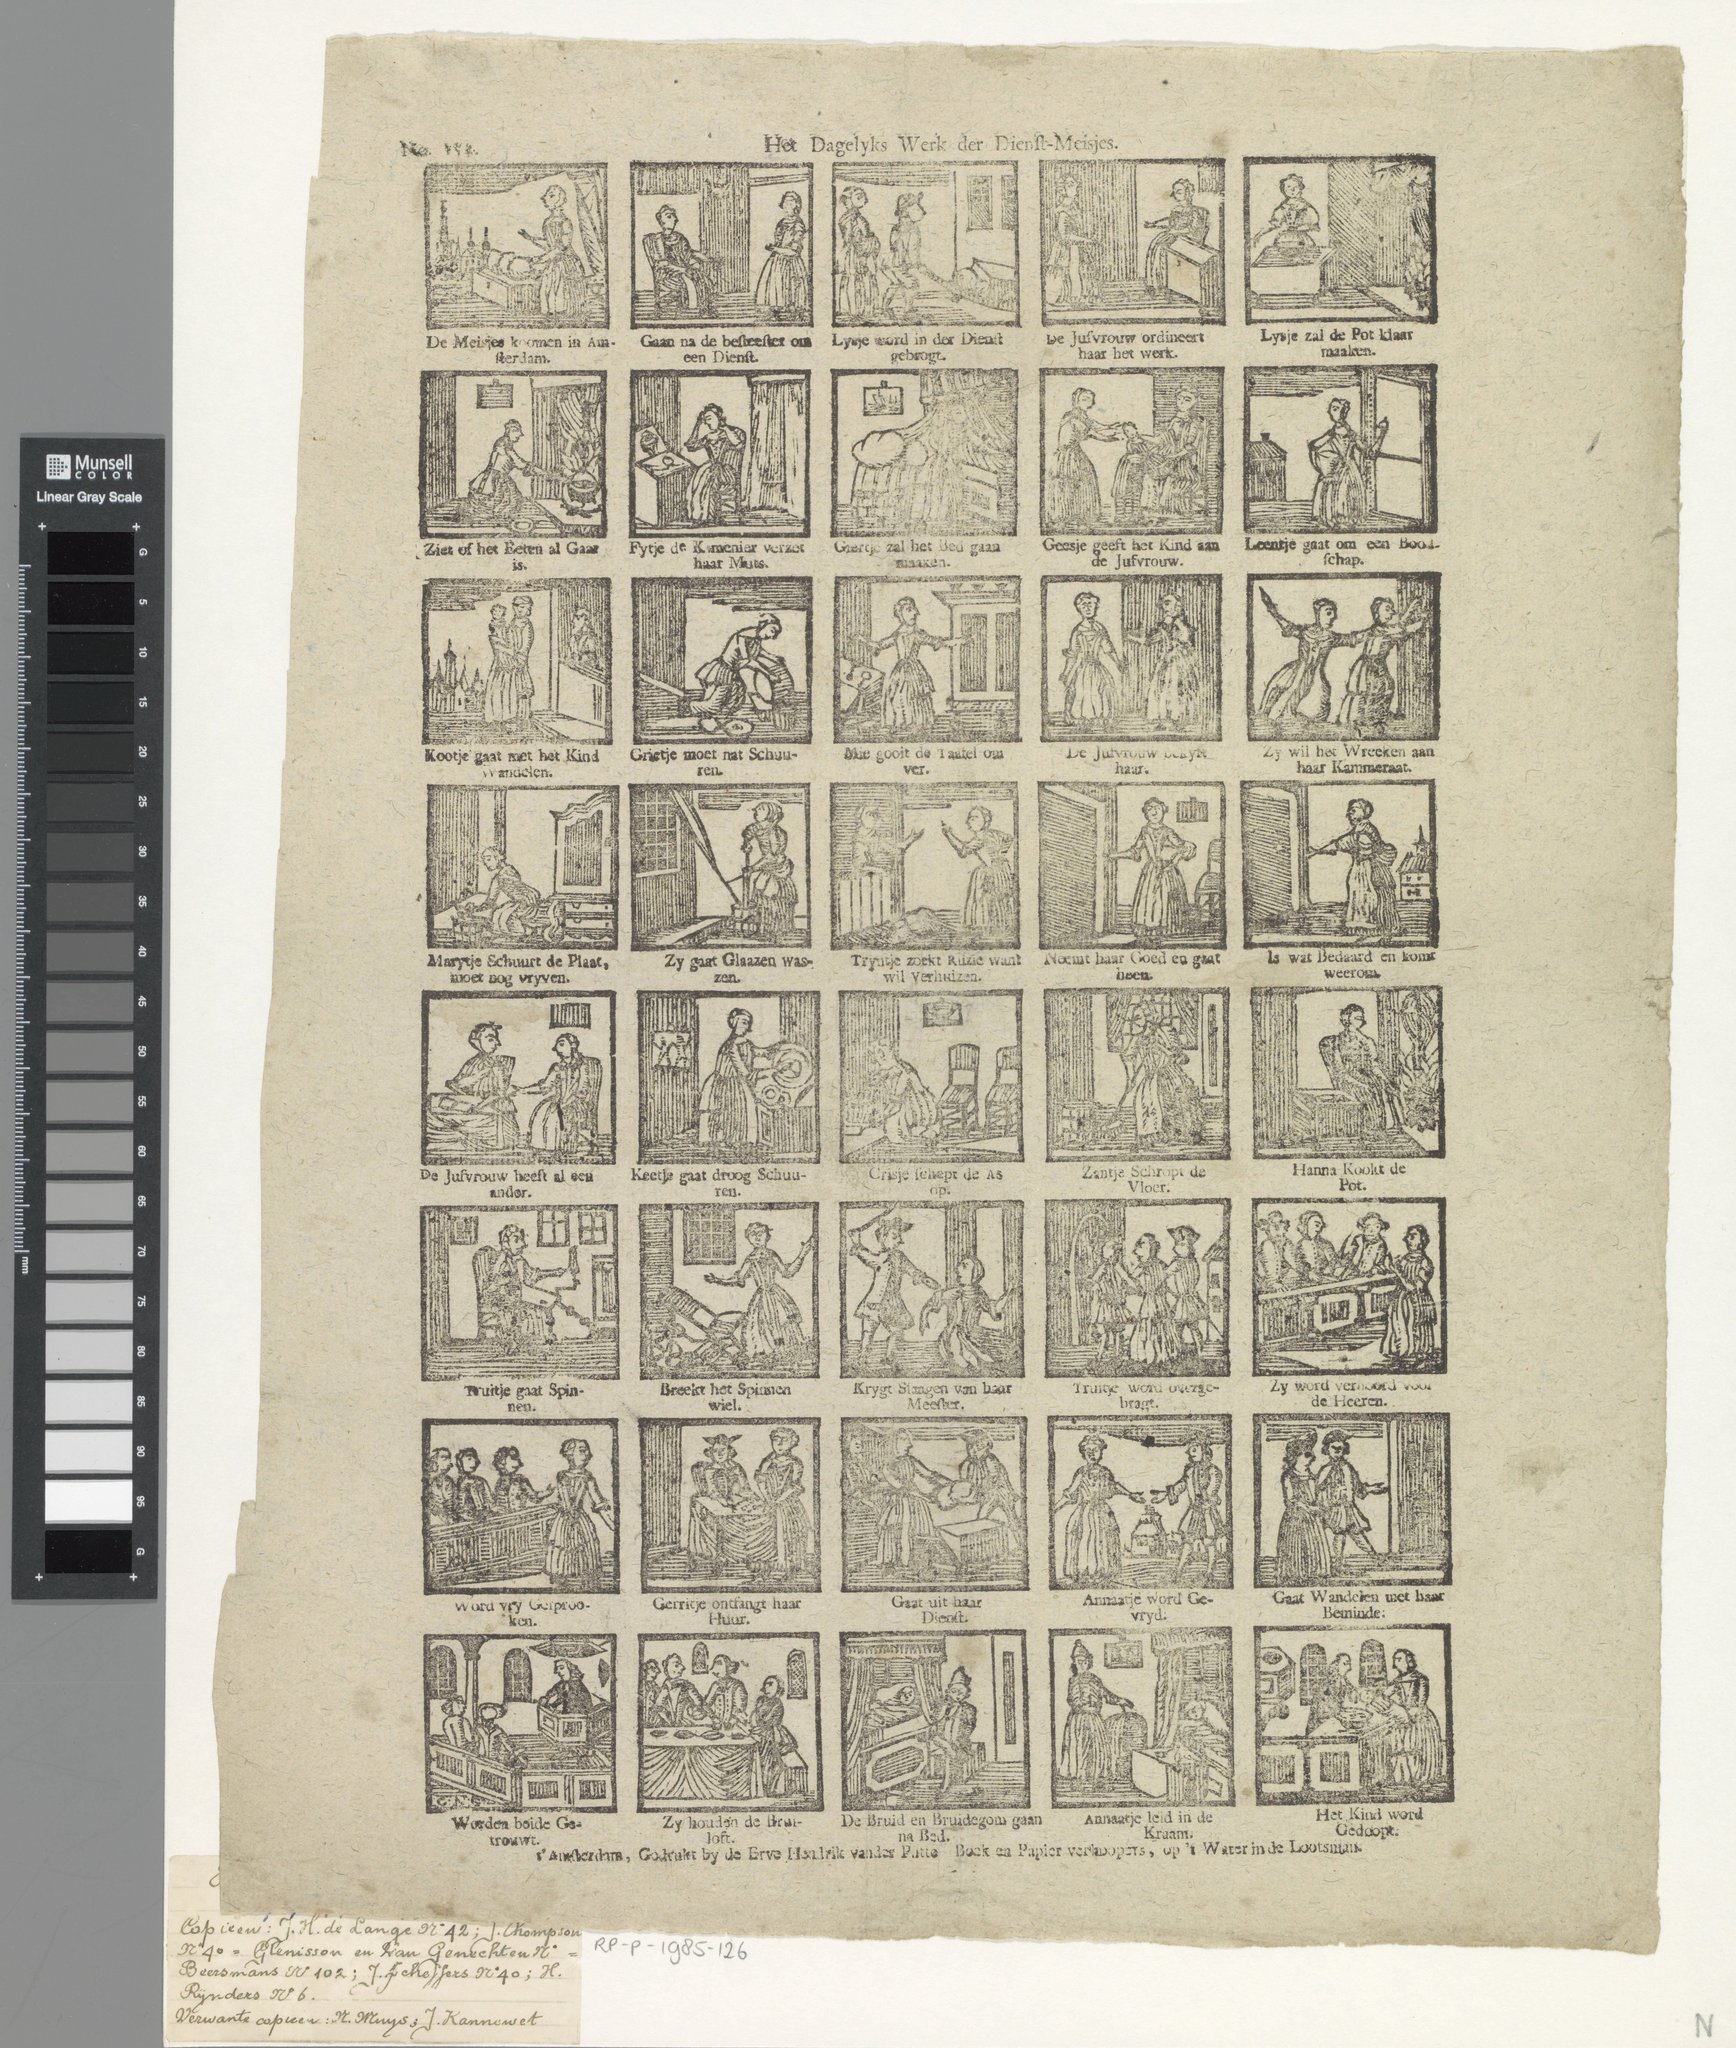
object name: print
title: Het dagelijks werk der dienst-meisjes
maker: Anonymous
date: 1767-1793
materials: paper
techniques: letterpress printing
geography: amsterdam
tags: maid ~ house personnel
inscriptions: collector's mark: Lugt 2760, collector's mark: Lugt 2228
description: Blad met 40 voorstellingen over de levens van dienstmeisjes, onder wie Geesje, Lyntje, Keetje en Annaatje. Onder elke afbeelding een onderschrift. Genummerd linksboven: No. 154.